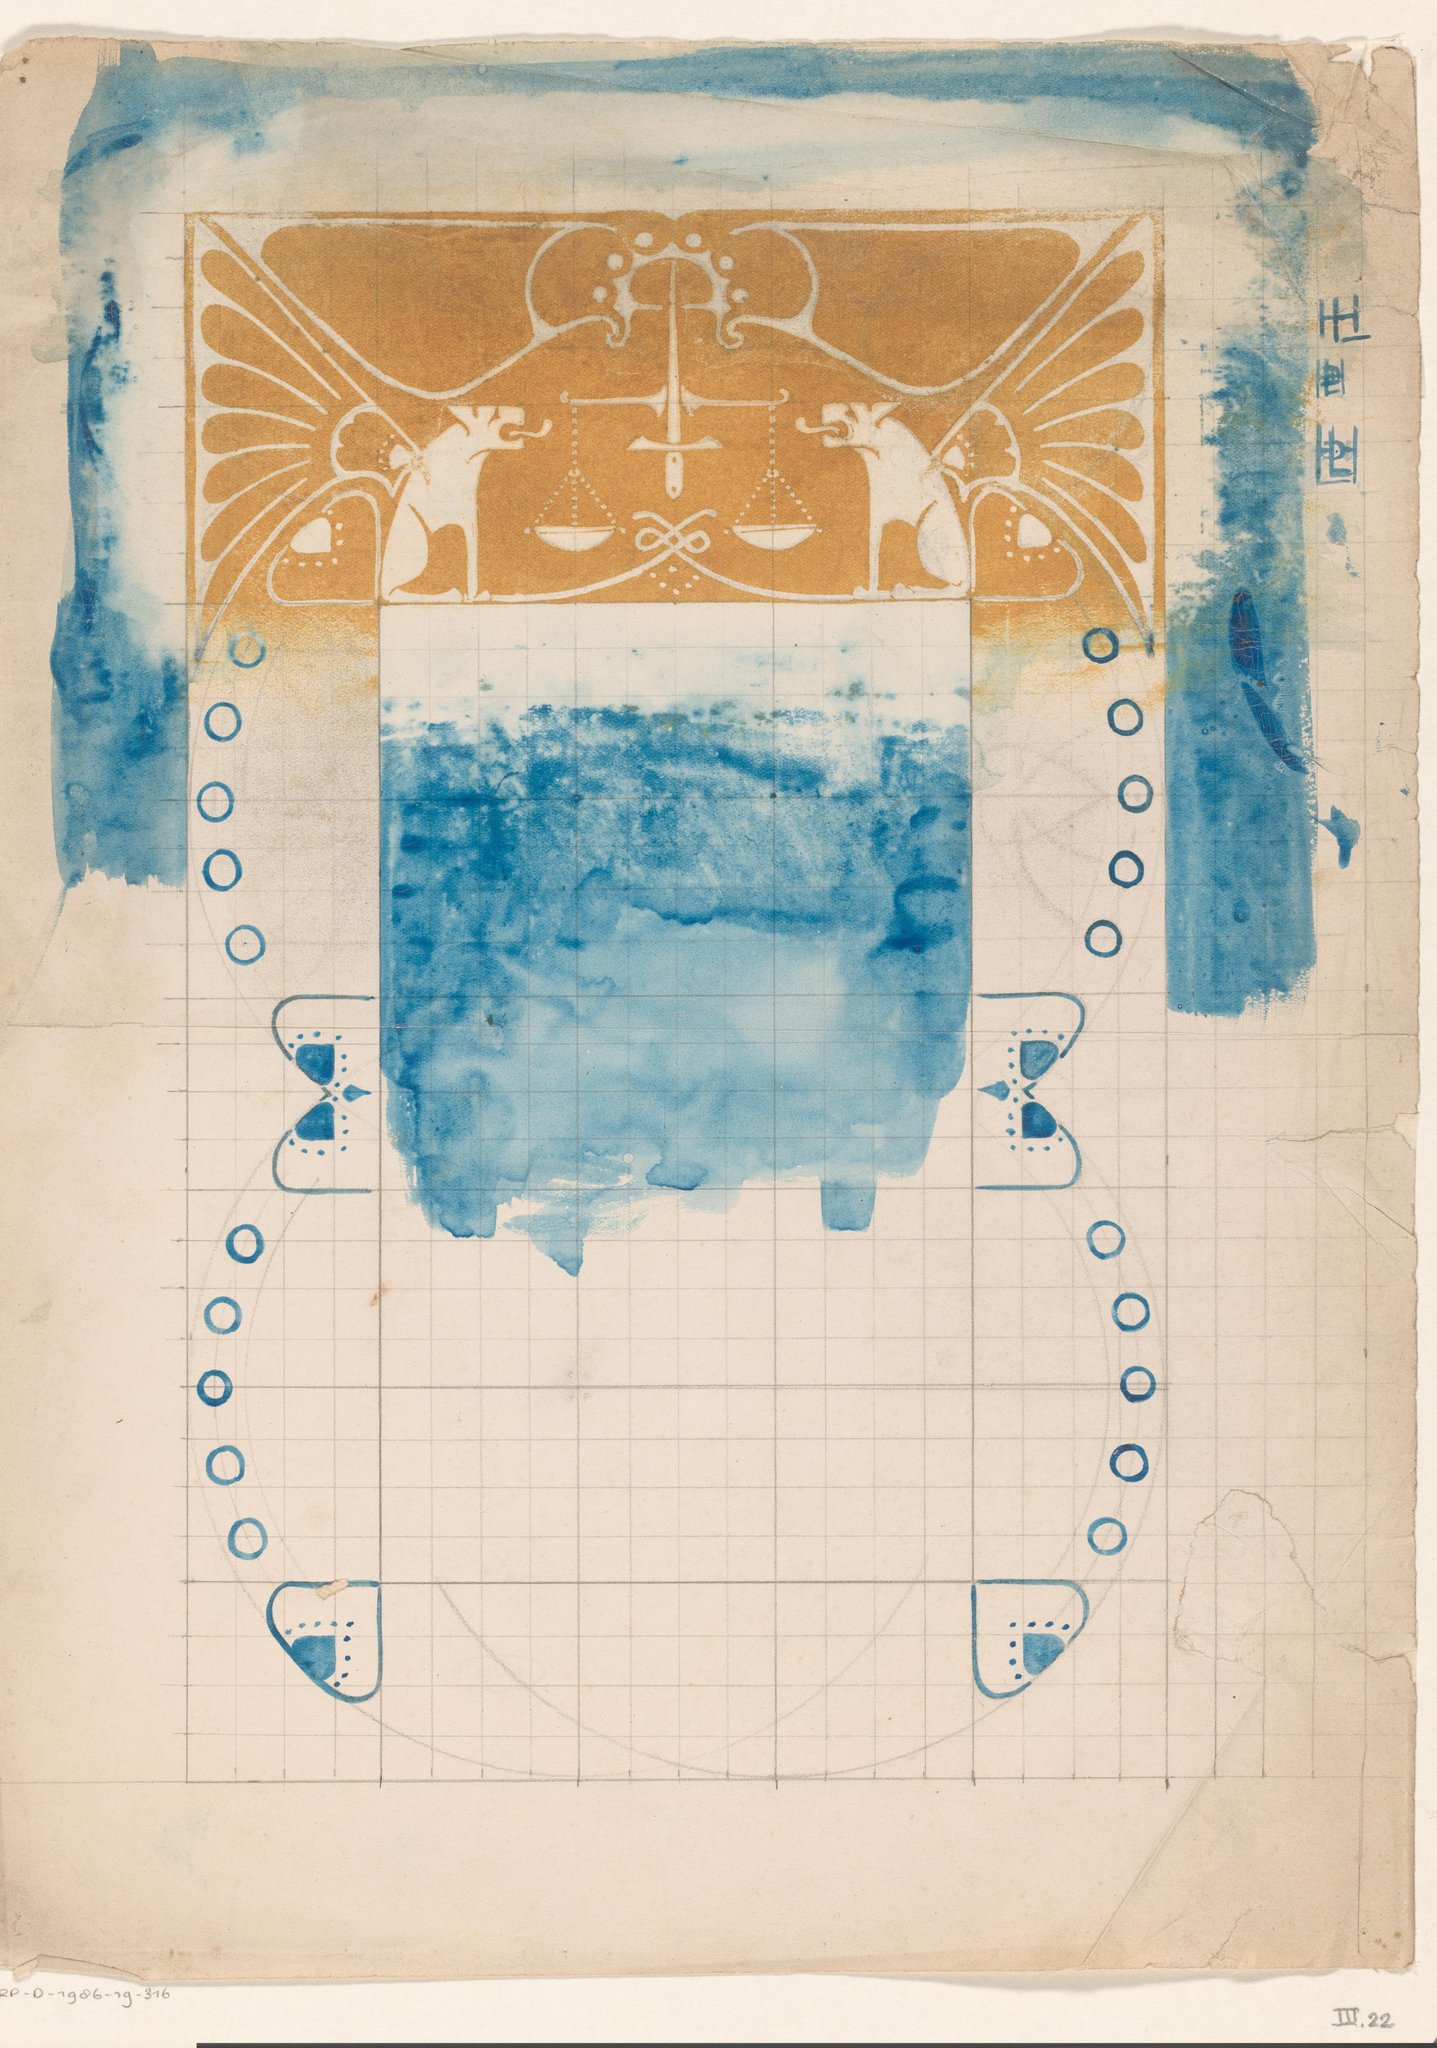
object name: design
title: Ontwerp voor een opdrachtblad voor een album voor Prof. Mr. L. den Hartog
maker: reinier willem petrus de vries (1874-1953)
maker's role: draughtsman, print maker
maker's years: 1874-1953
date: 1902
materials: ink, paper, pencil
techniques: brush, lithograph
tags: ornament derived from animal forms, scales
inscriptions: collector's mark: ‘R:MVS.’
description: Rechthoekig kader met cirkels. Bovenaan het kader twee gevleugelde dieren aan weerszijden van een weegschaal.